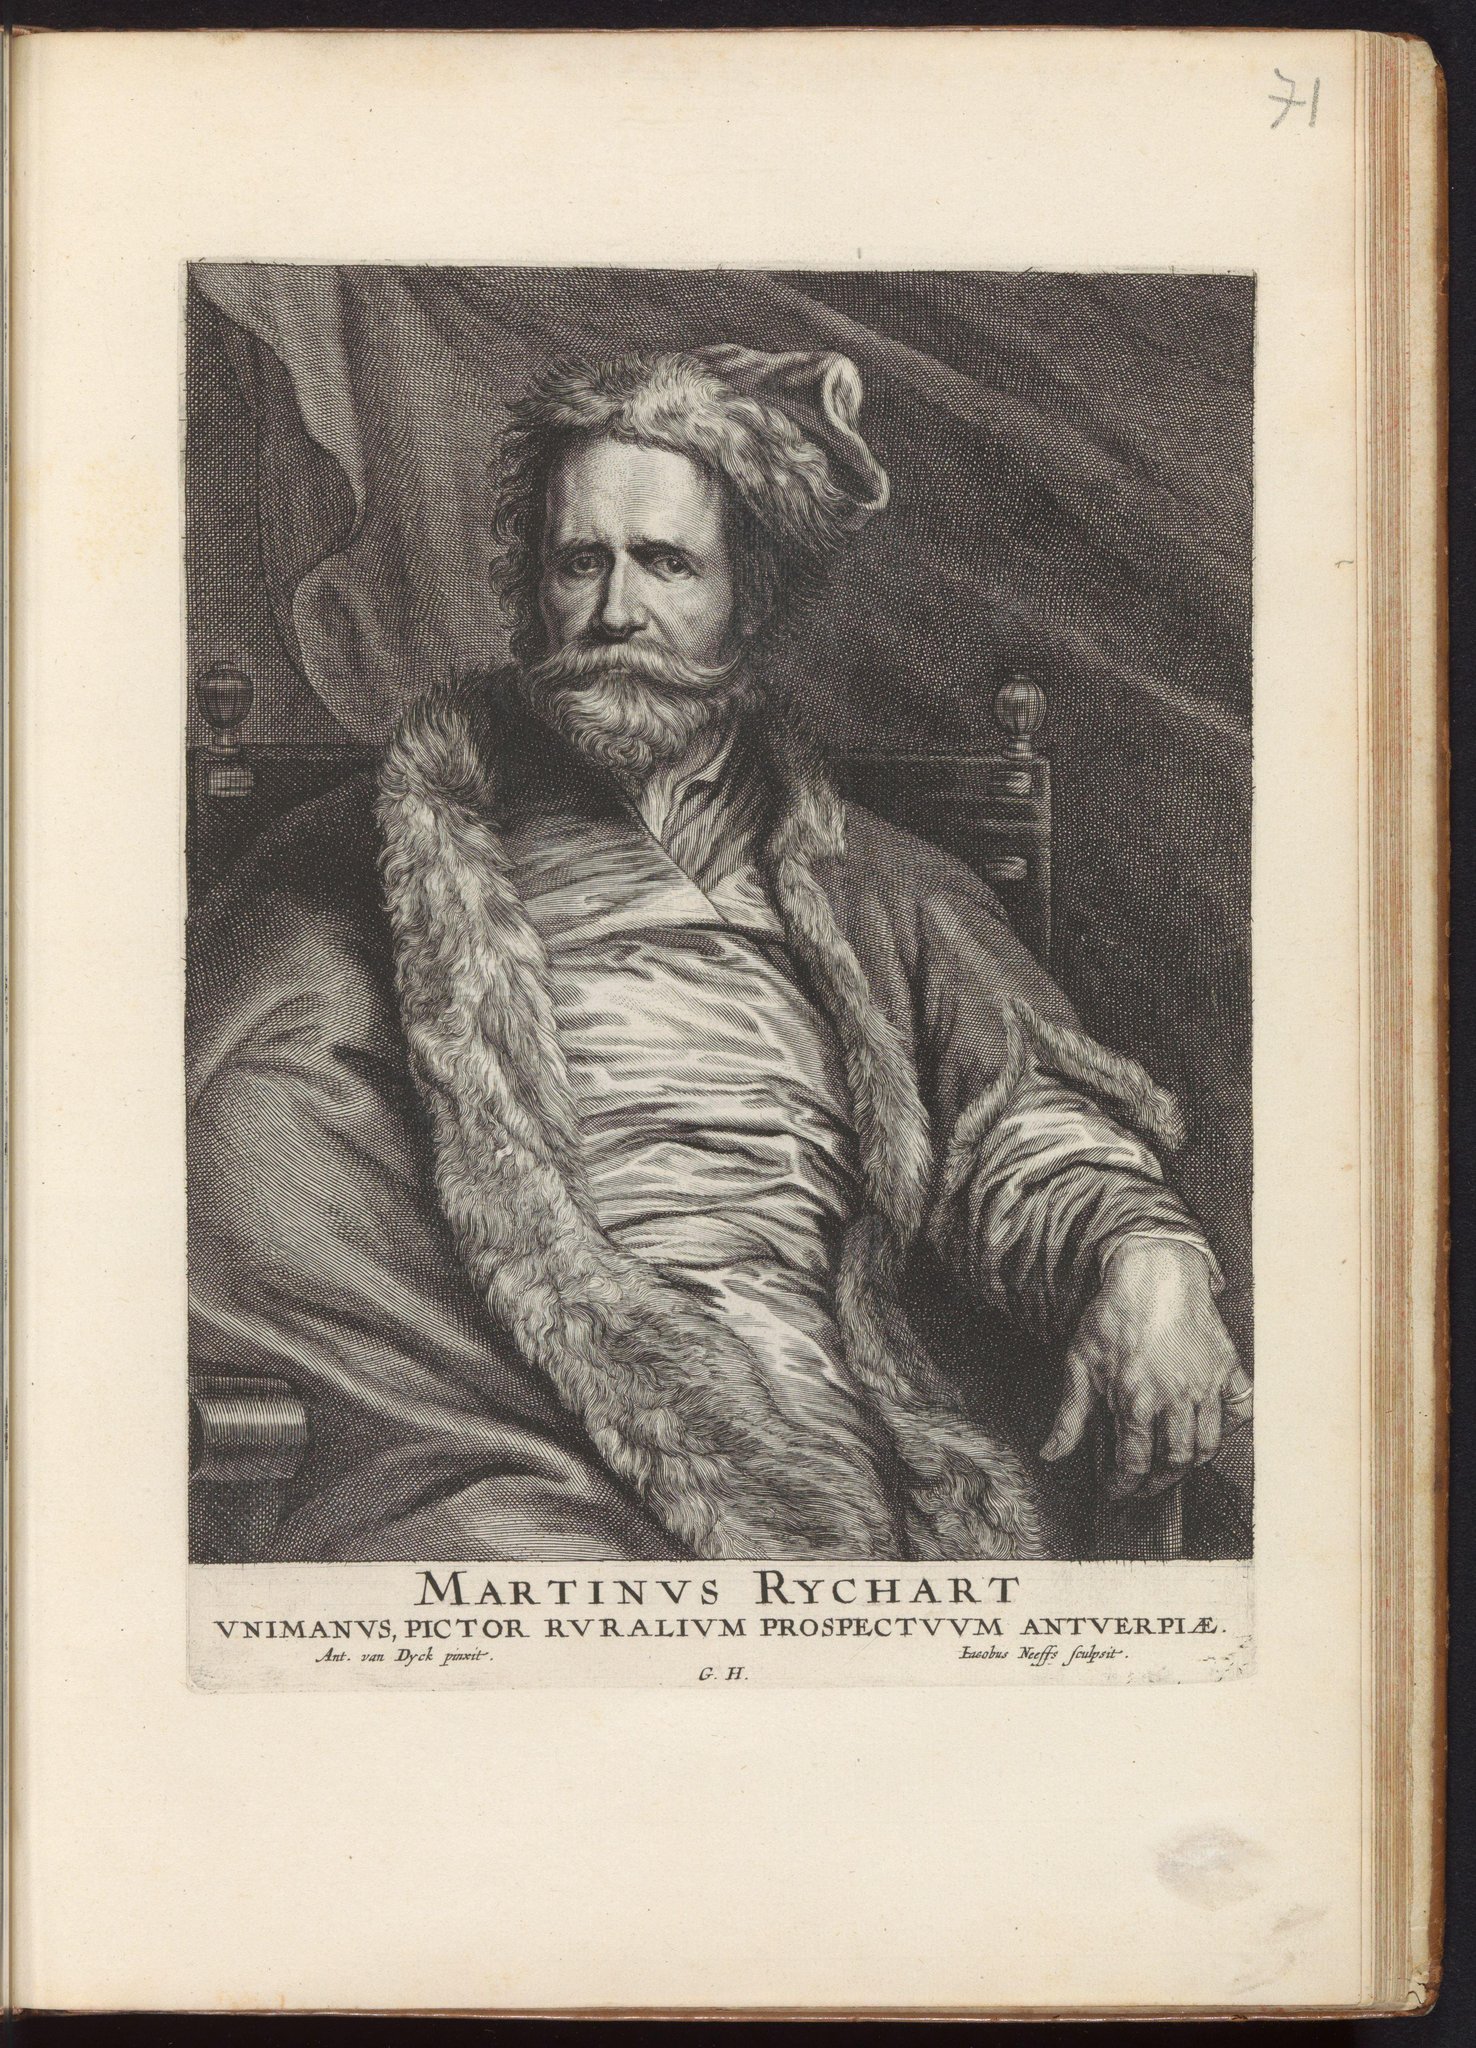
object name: album leaf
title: Portret van de schilder Marten Rijckaert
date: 1641-1645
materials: paper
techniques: engraving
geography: antwerp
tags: antwerp, painter, marten rijckaert, portrait, self-portrait of painter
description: Deze prent maakt deel uit van een album.